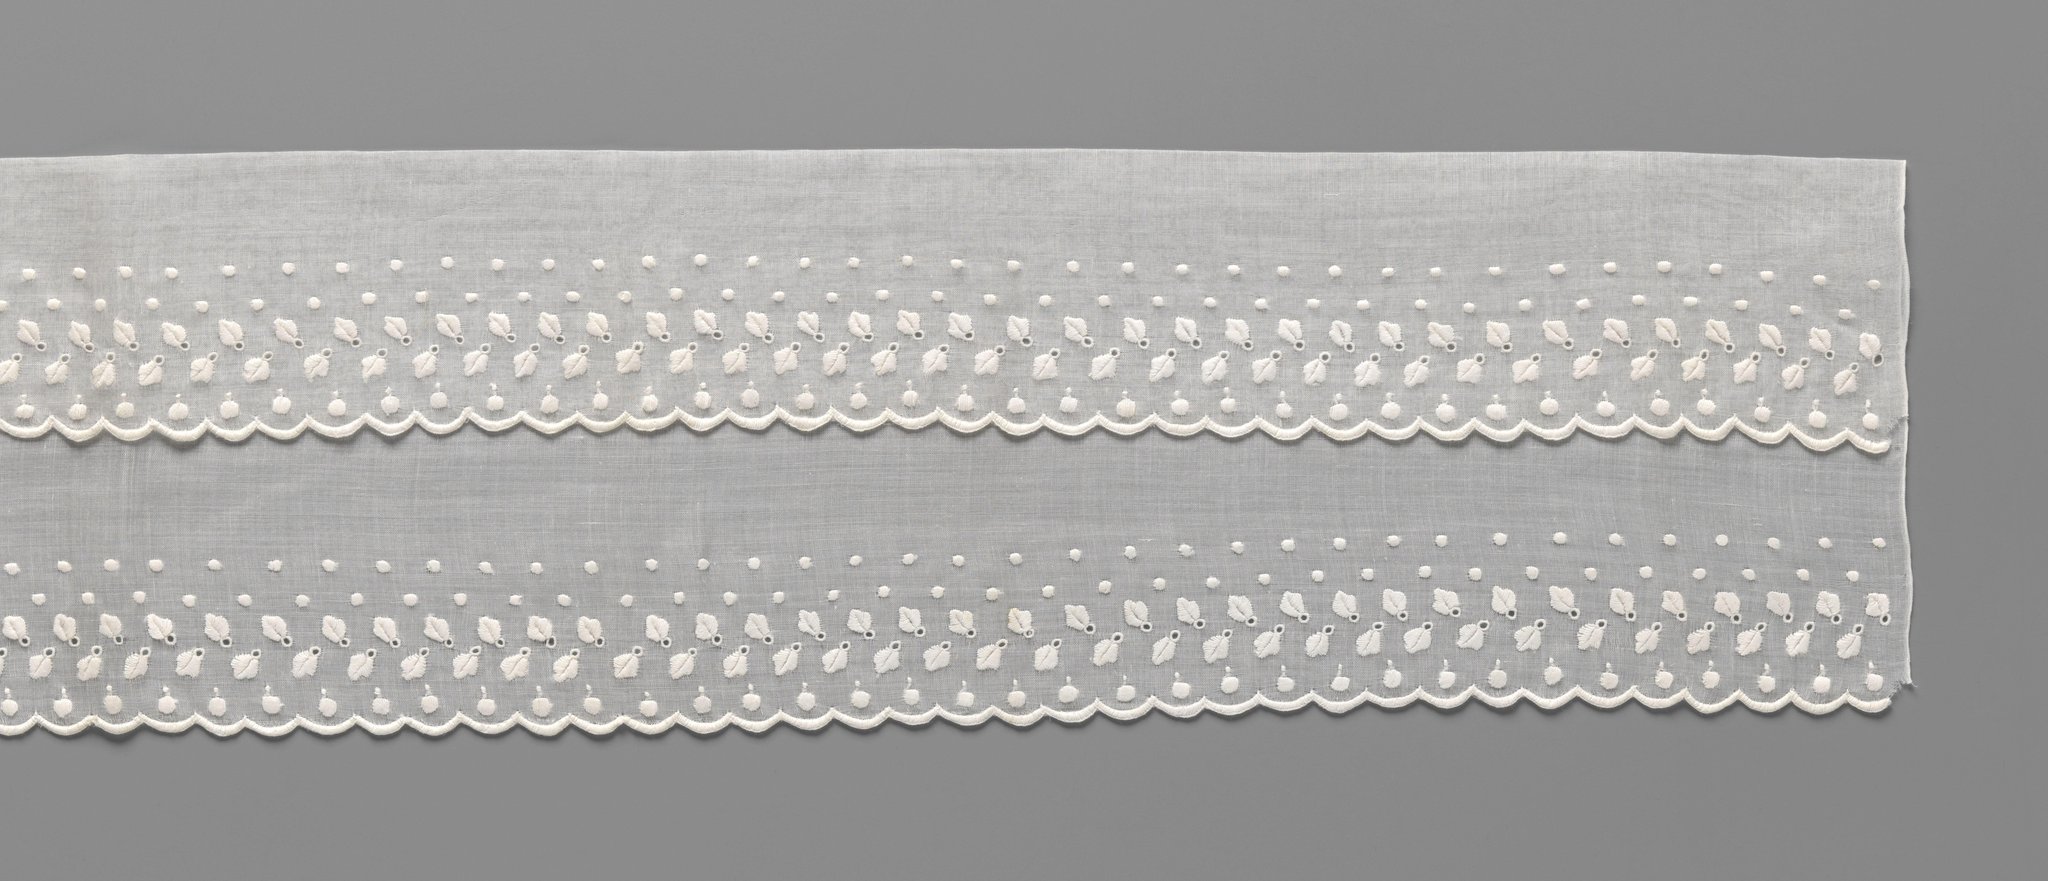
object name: strip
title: Strook glasbatist met witwerk met rijen blaadjes en stipjes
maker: Anonymous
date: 1850-1870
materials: glass batiste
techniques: embroidered, weave, embroidery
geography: switzerland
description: Japonstrook naturelkleurig glasbatist met witwerk. Langs boven- en onderrand loopt een schulpenrand met in elke schulp een stip met een klein stipje daarboven en verder naar boven twee rijen bladeren en twee rijen stippen. Aan elk blaadje zit in plaats van een steeltje een opengewerkt cirkeltje.